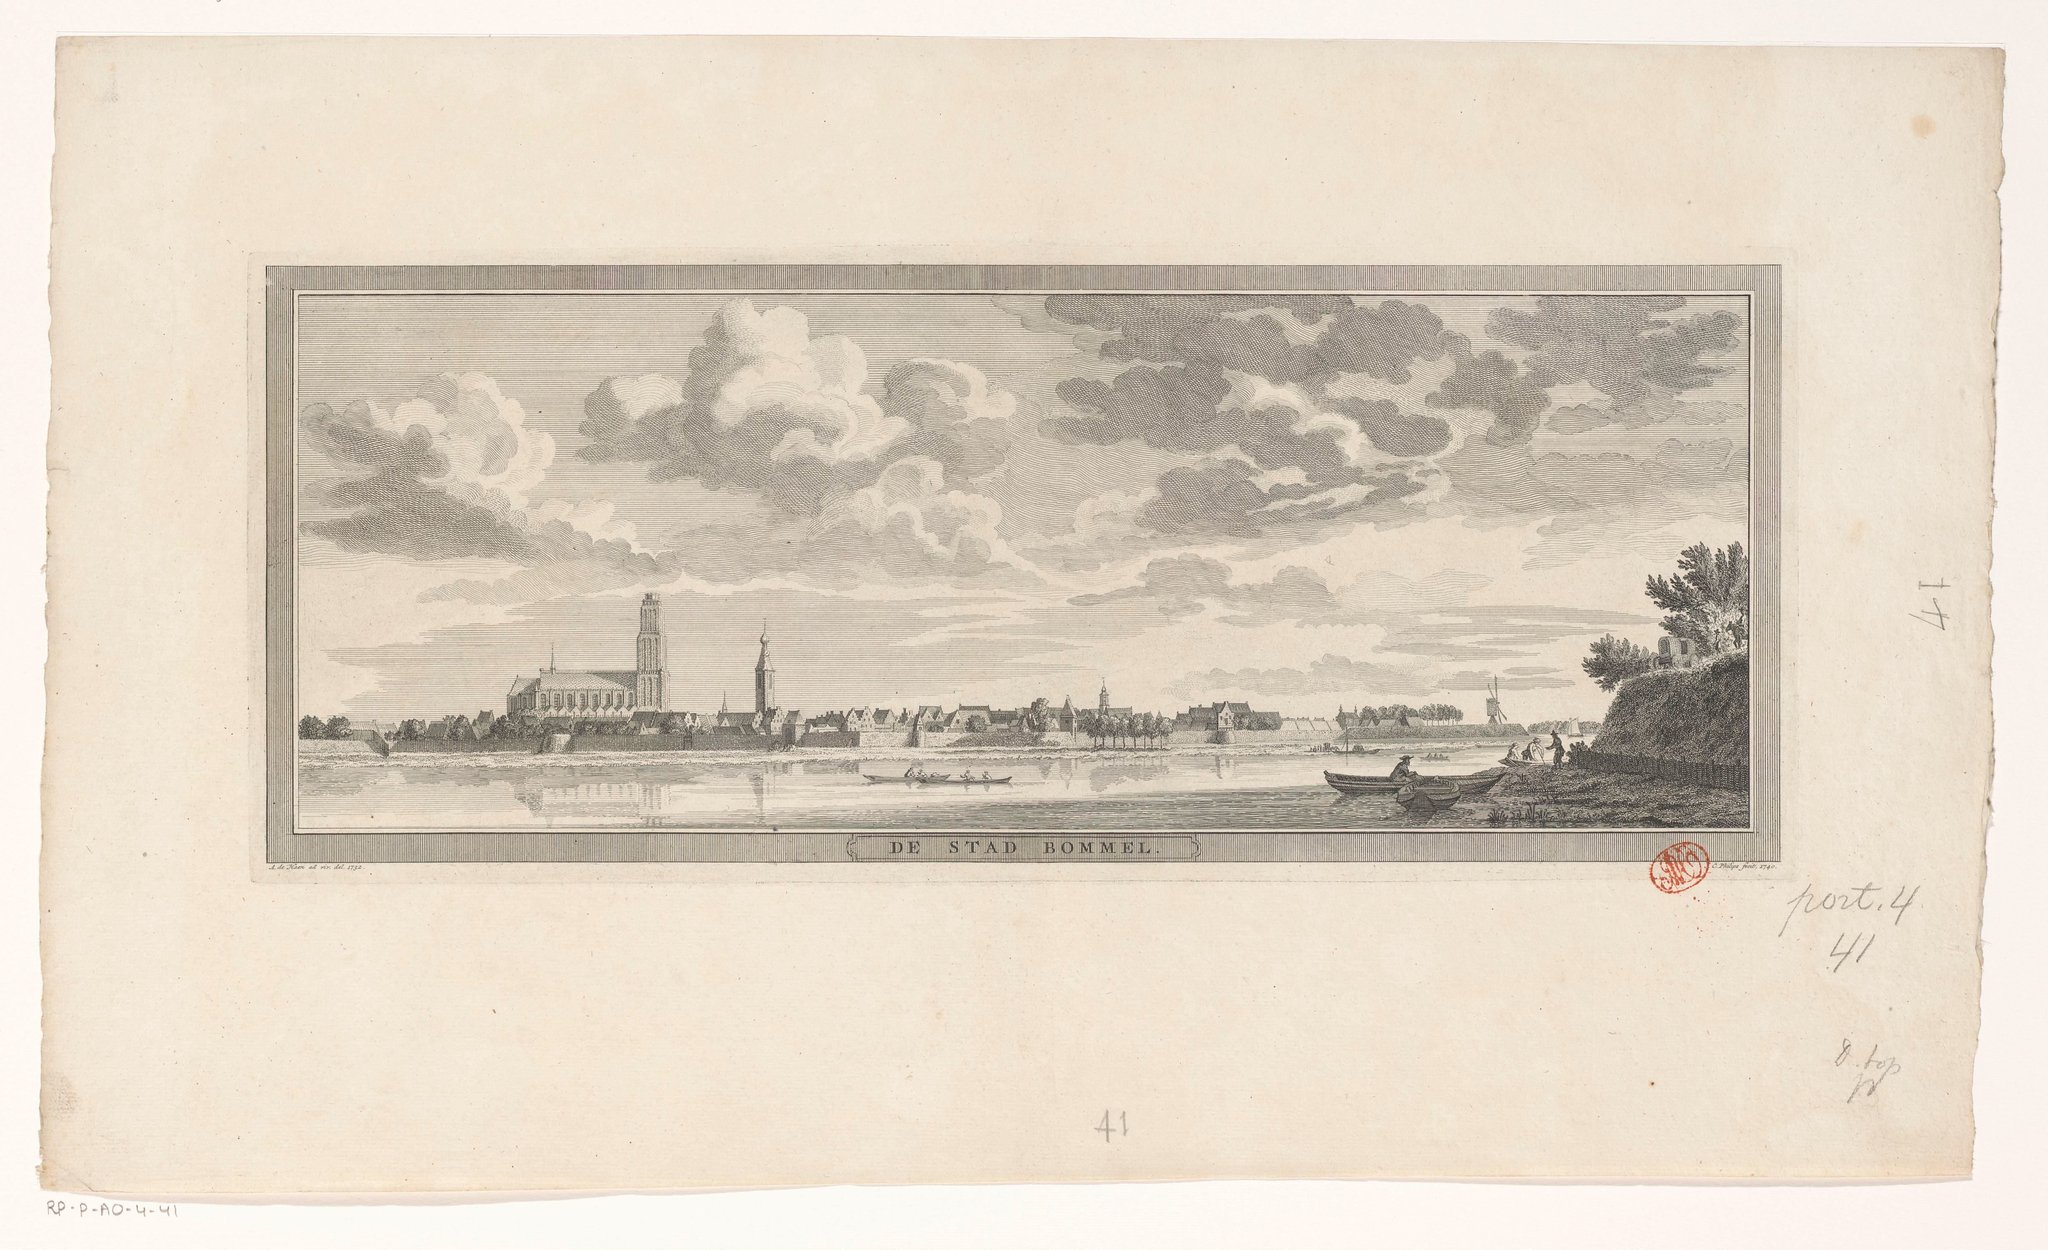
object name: book illustration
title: Gezicht op Zaltbommel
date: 1740-1741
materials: paper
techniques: etching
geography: amsterdam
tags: city-view in general; 'veduta'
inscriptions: collector's mark: Lugt 195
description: Prent ook gebruikt in: Wagenaar, Jan. Tegenwoordige staat der Vereenigde Nederlanden, derde deel. Vervattende de beschryving der provincie Gelderland (…) / Hedendaagsche historie of tegenwoordige staat van alle volkeren: XIIIde deel. Vervolgende de (…) en vervattende byzonderlyk die der provincie Gelderland (…). Amsterdam: Isaak Tirion, 1741.